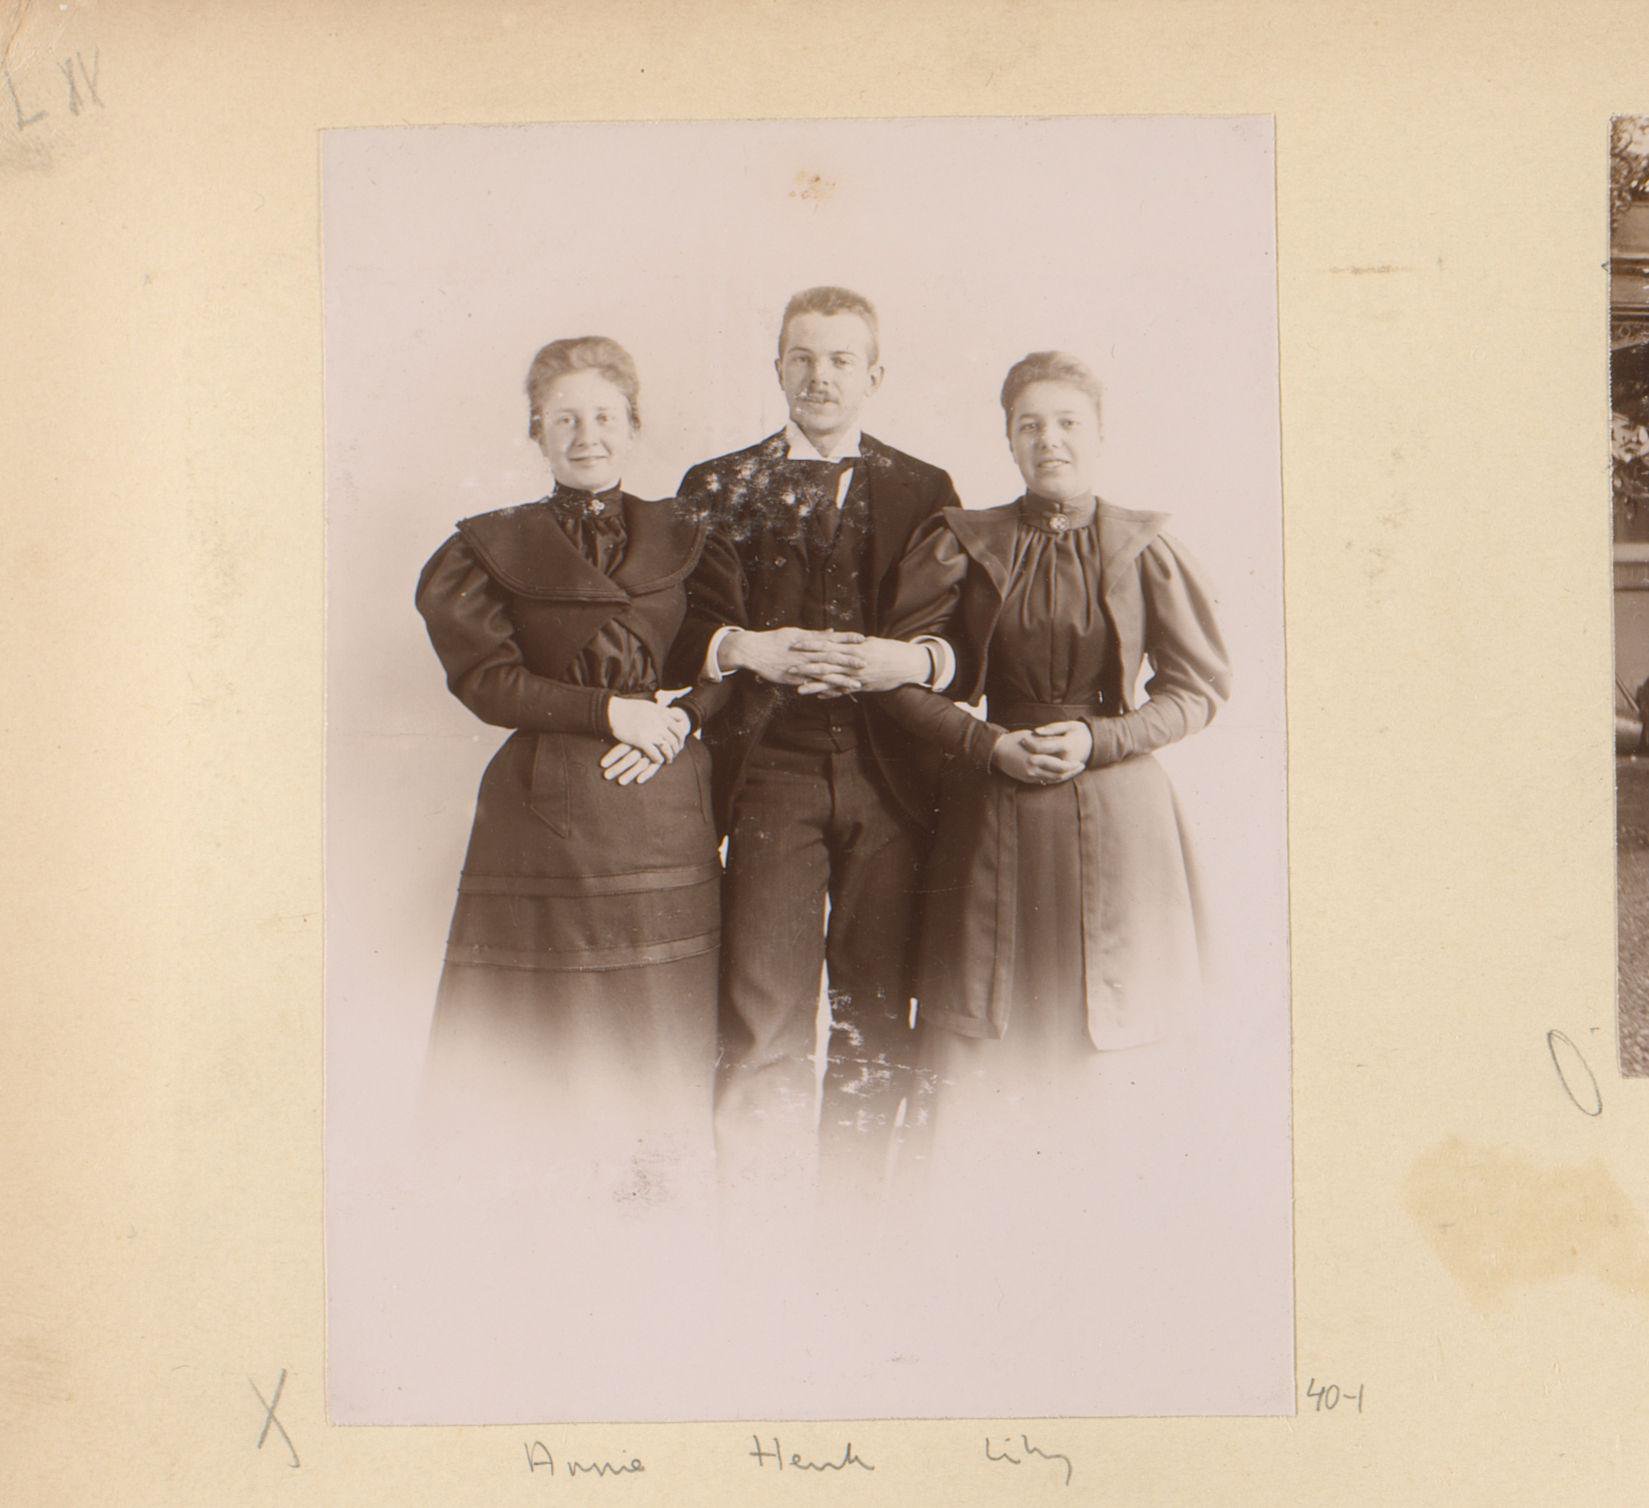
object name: photograph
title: Fotoreproductie van een gefotografeerd portret van Annie en Lily Holle en Henk van den Berg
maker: hendrik herman van den berg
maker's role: amateurfotograaf, jurist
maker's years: 1875-1944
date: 1890-1894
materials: paper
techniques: collodion silver print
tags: amsterdam, hendrik herman van den berg, batavia, historical persons - bb - woman, historical persons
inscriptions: caption: ‘Annie, Henk, Lily’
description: Foto 1 op albumblad 40 uit album "Amsterdam 1890-1894".